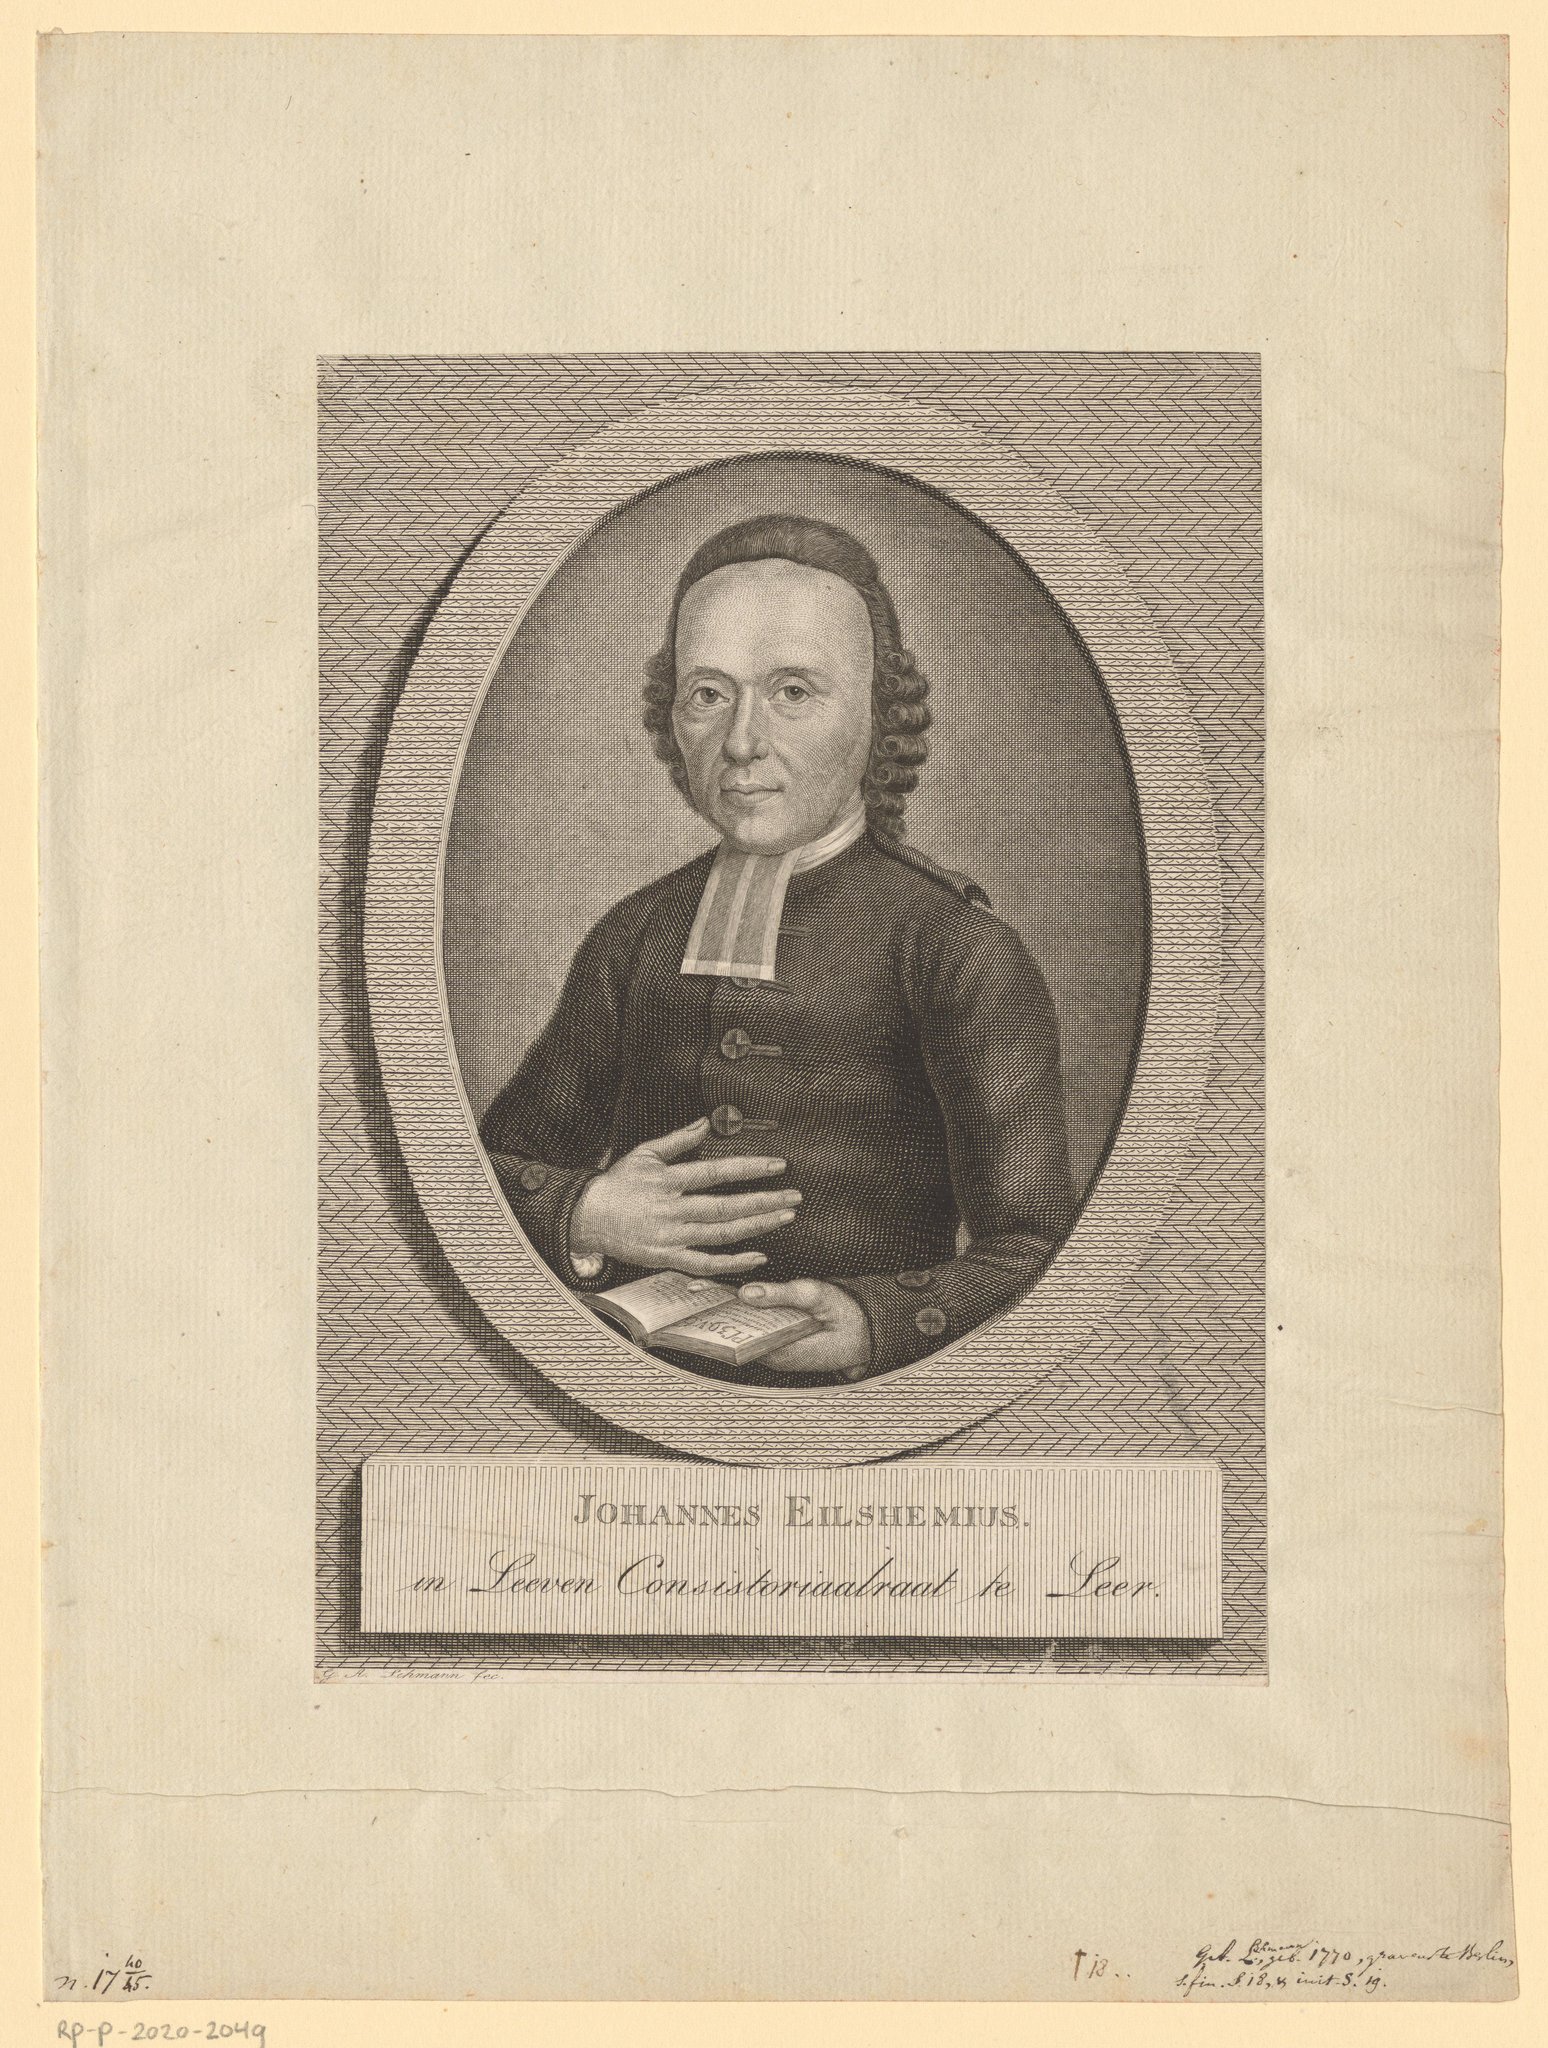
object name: print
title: Portret van Johannes Eilshemius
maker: gottfried arnold lehman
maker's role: print maker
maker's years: 1770-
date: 1790-1819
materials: paper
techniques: engraving, etching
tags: historical persons